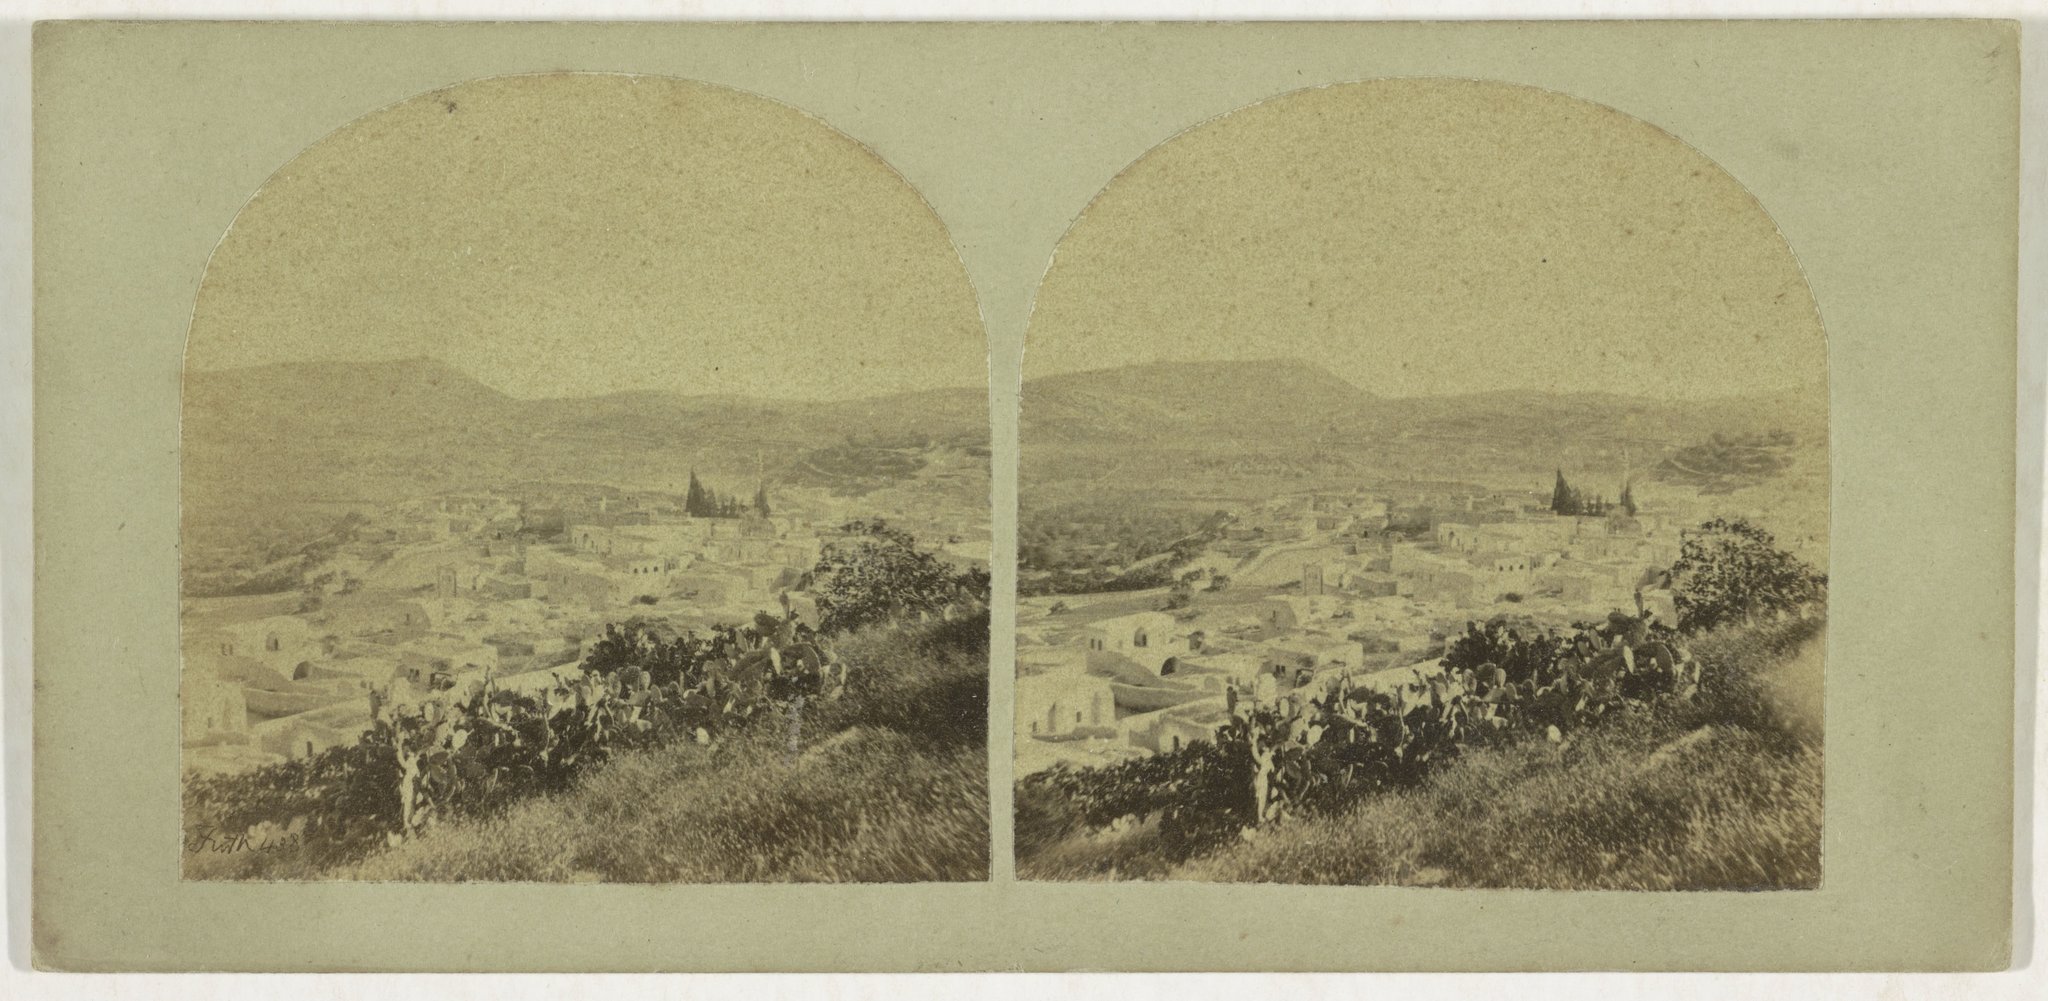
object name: stereograph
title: Views in the Holy Land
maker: francis frith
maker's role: publisher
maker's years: 1822-1898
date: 1858-1859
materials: cardboard, paper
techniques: albumen print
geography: nazareth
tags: city-view in general; 'veduta'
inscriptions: inscription: ‘438’, inscription: ‘No town in Palestine can possess equal interest to nazareth, from its having been the residence of the Saviour, (...)’, inscription: ‘[Deposé.’, inscription: ‘Entered at Stationers' Hall.]’, number: ‘444’